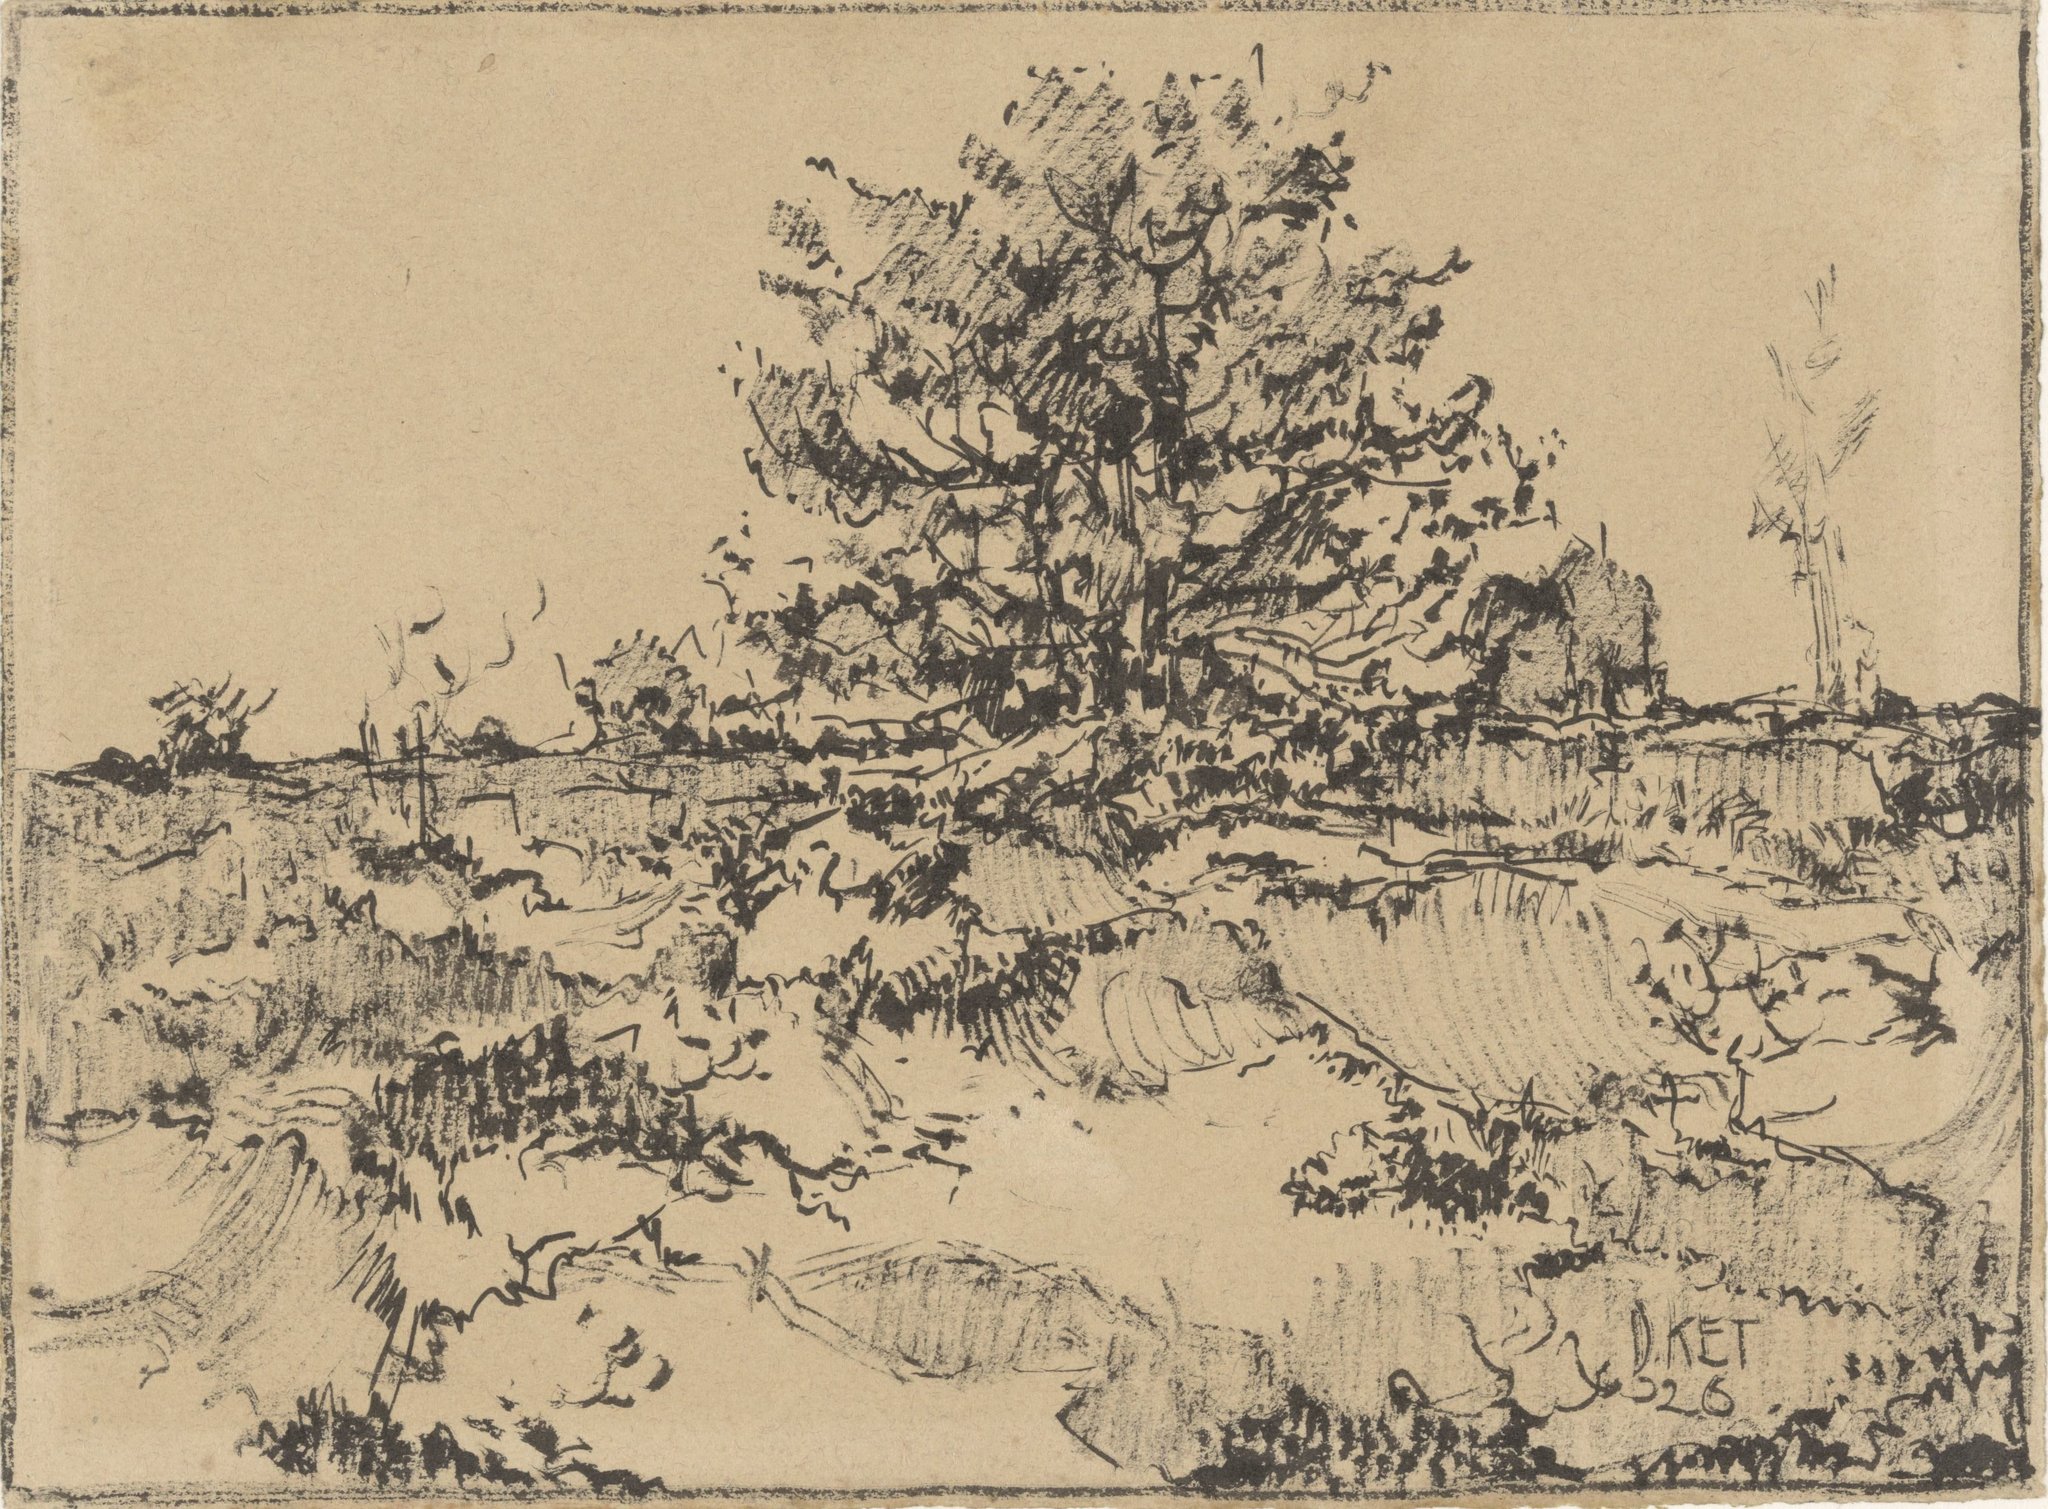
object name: drawing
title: Heide bij Ede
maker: dick ket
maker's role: draughtsman, print maker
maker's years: 1902-1940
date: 1926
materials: ink, paper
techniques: pen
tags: trees, grasslands, savanna, prairie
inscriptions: collector's mark: Lugt 2228